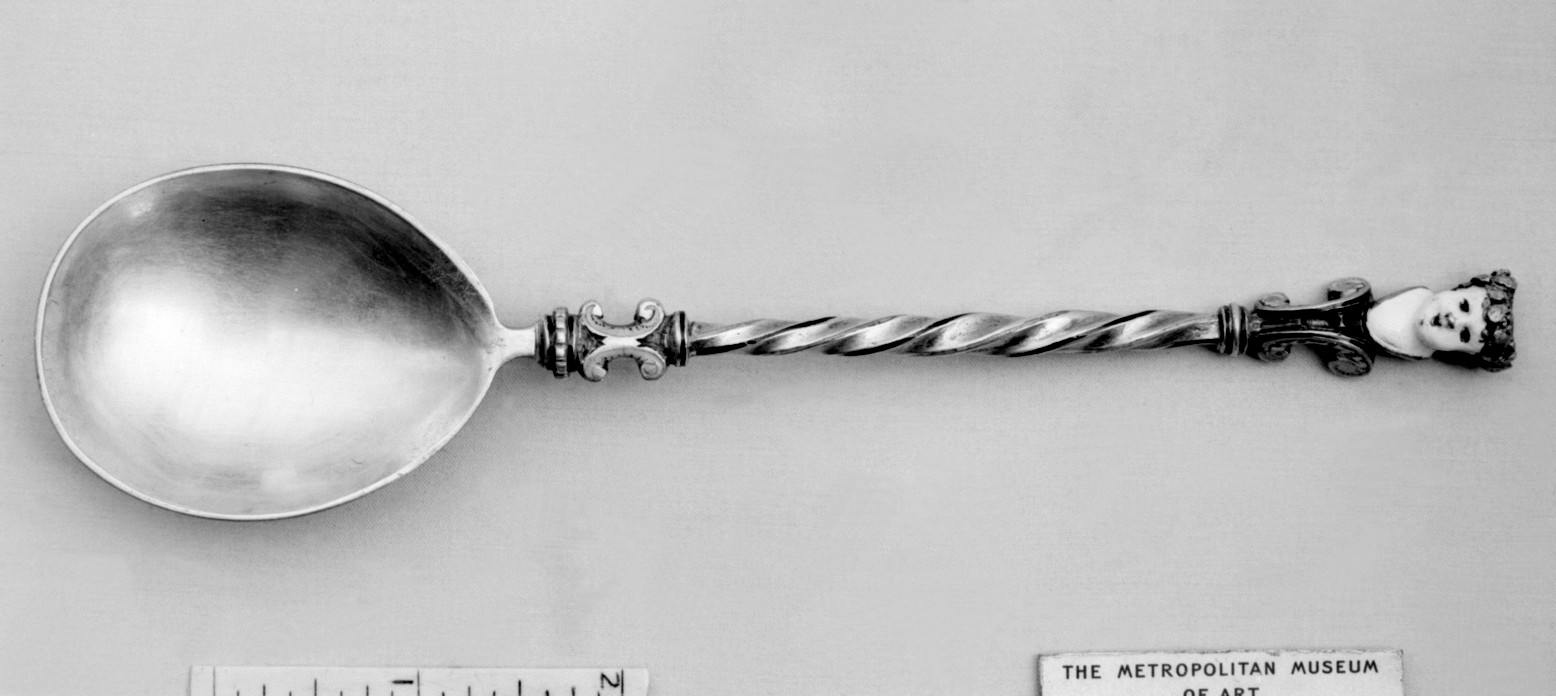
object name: spoon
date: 1601-1700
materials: gilt, silver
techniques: enamel